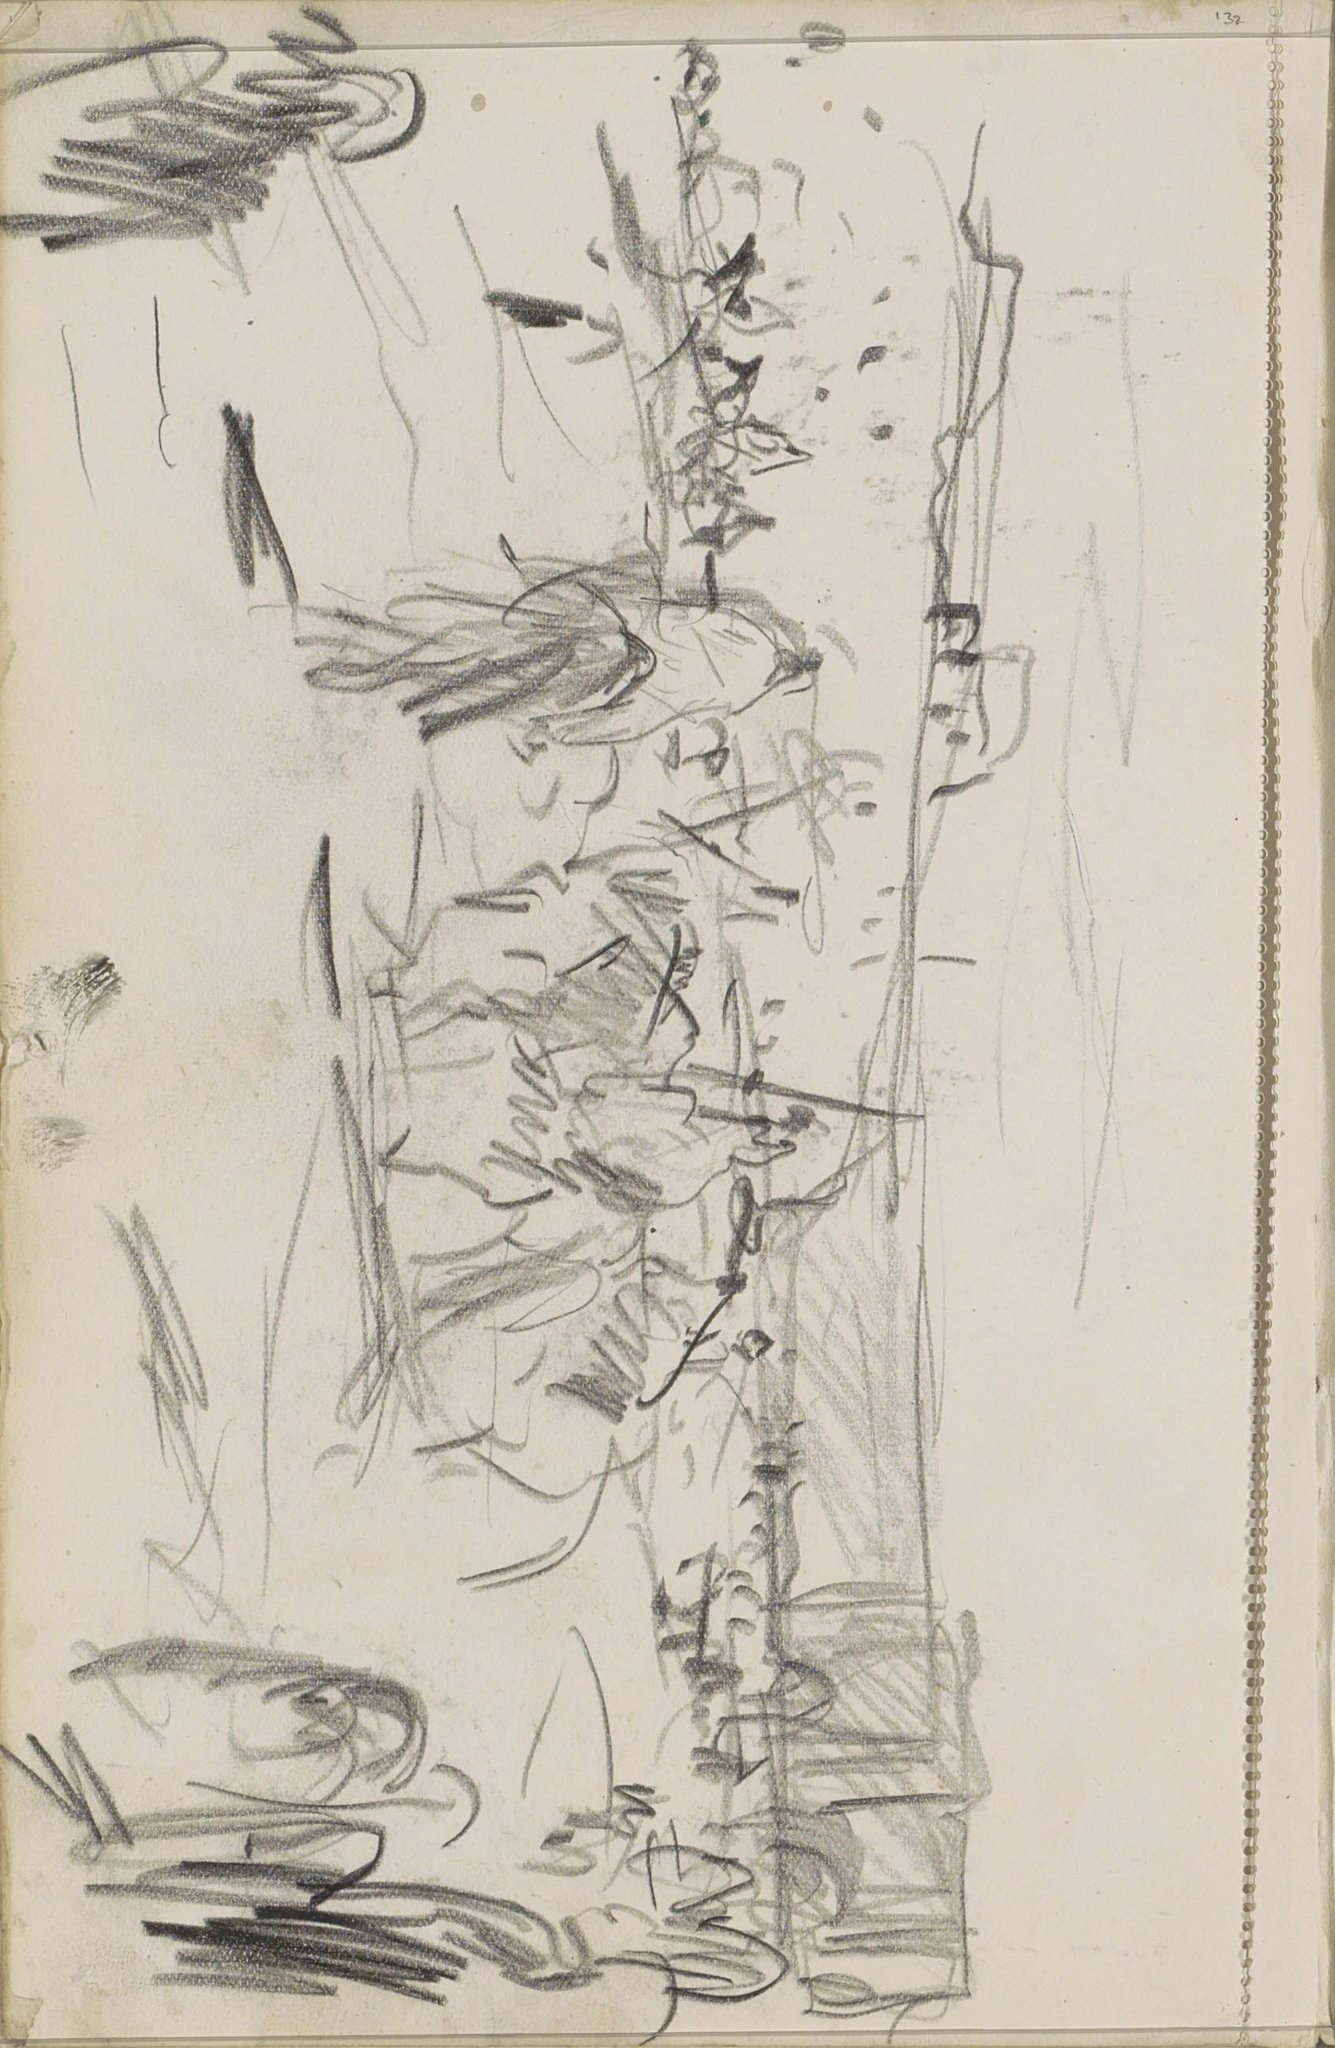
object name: sketchbook leaf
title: Ruiters op het plein bij de Bab Mansour poort in Meknès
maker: marius bauer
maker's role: draughtsman, print maker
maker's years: 1867-1932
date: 1923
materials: paper, pencil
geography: morocco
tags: riding a horse, ass, or mule; rider, horseman, square, place, circus, etc., street (+ city(-scape) with figures, staffage)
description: Pagina 132 uit een schetsboek met 66 bladen.